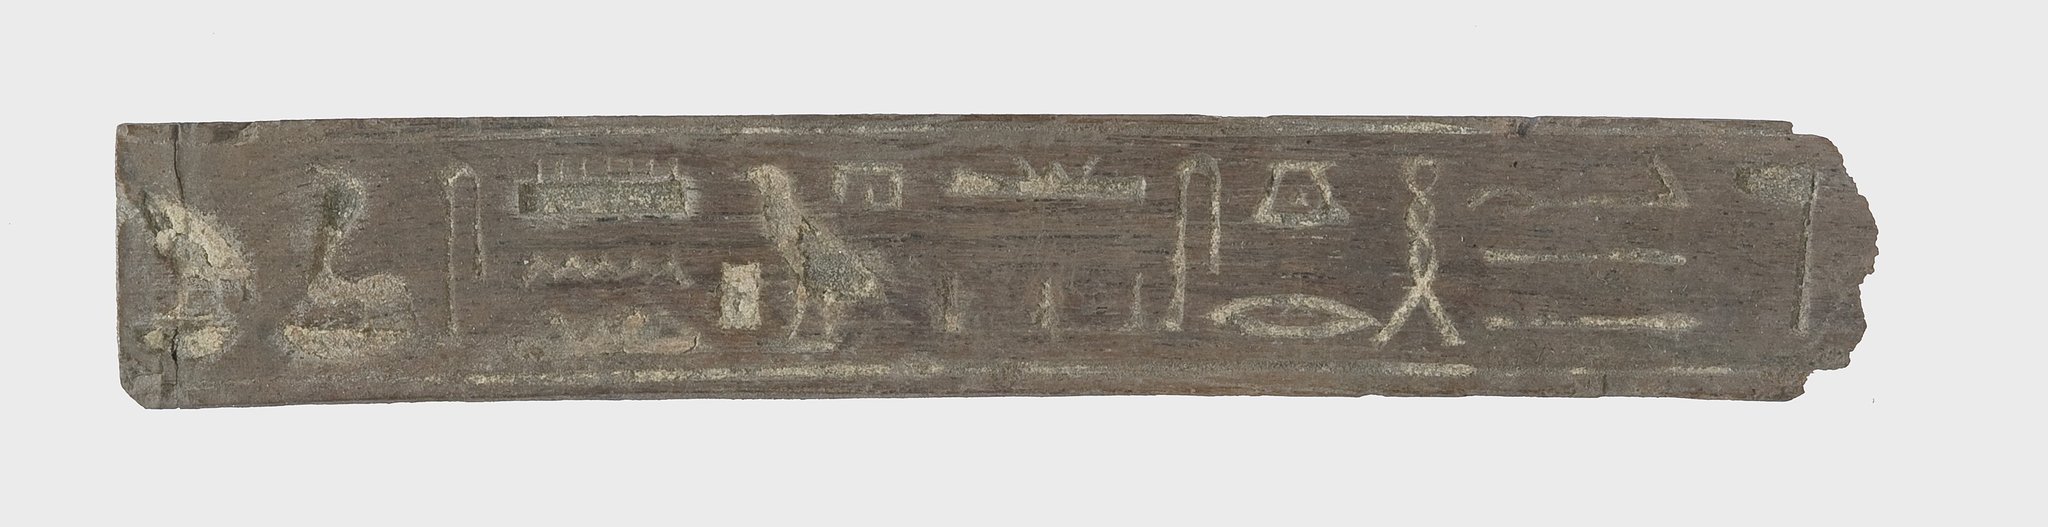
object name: inlay fragment, wood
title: Wooden fragment for inlay inscribed with the Two-Ladies name of Amenhotep III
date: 1390-1352 BCE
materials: paint, wood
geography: egypt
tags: hieroglyphs